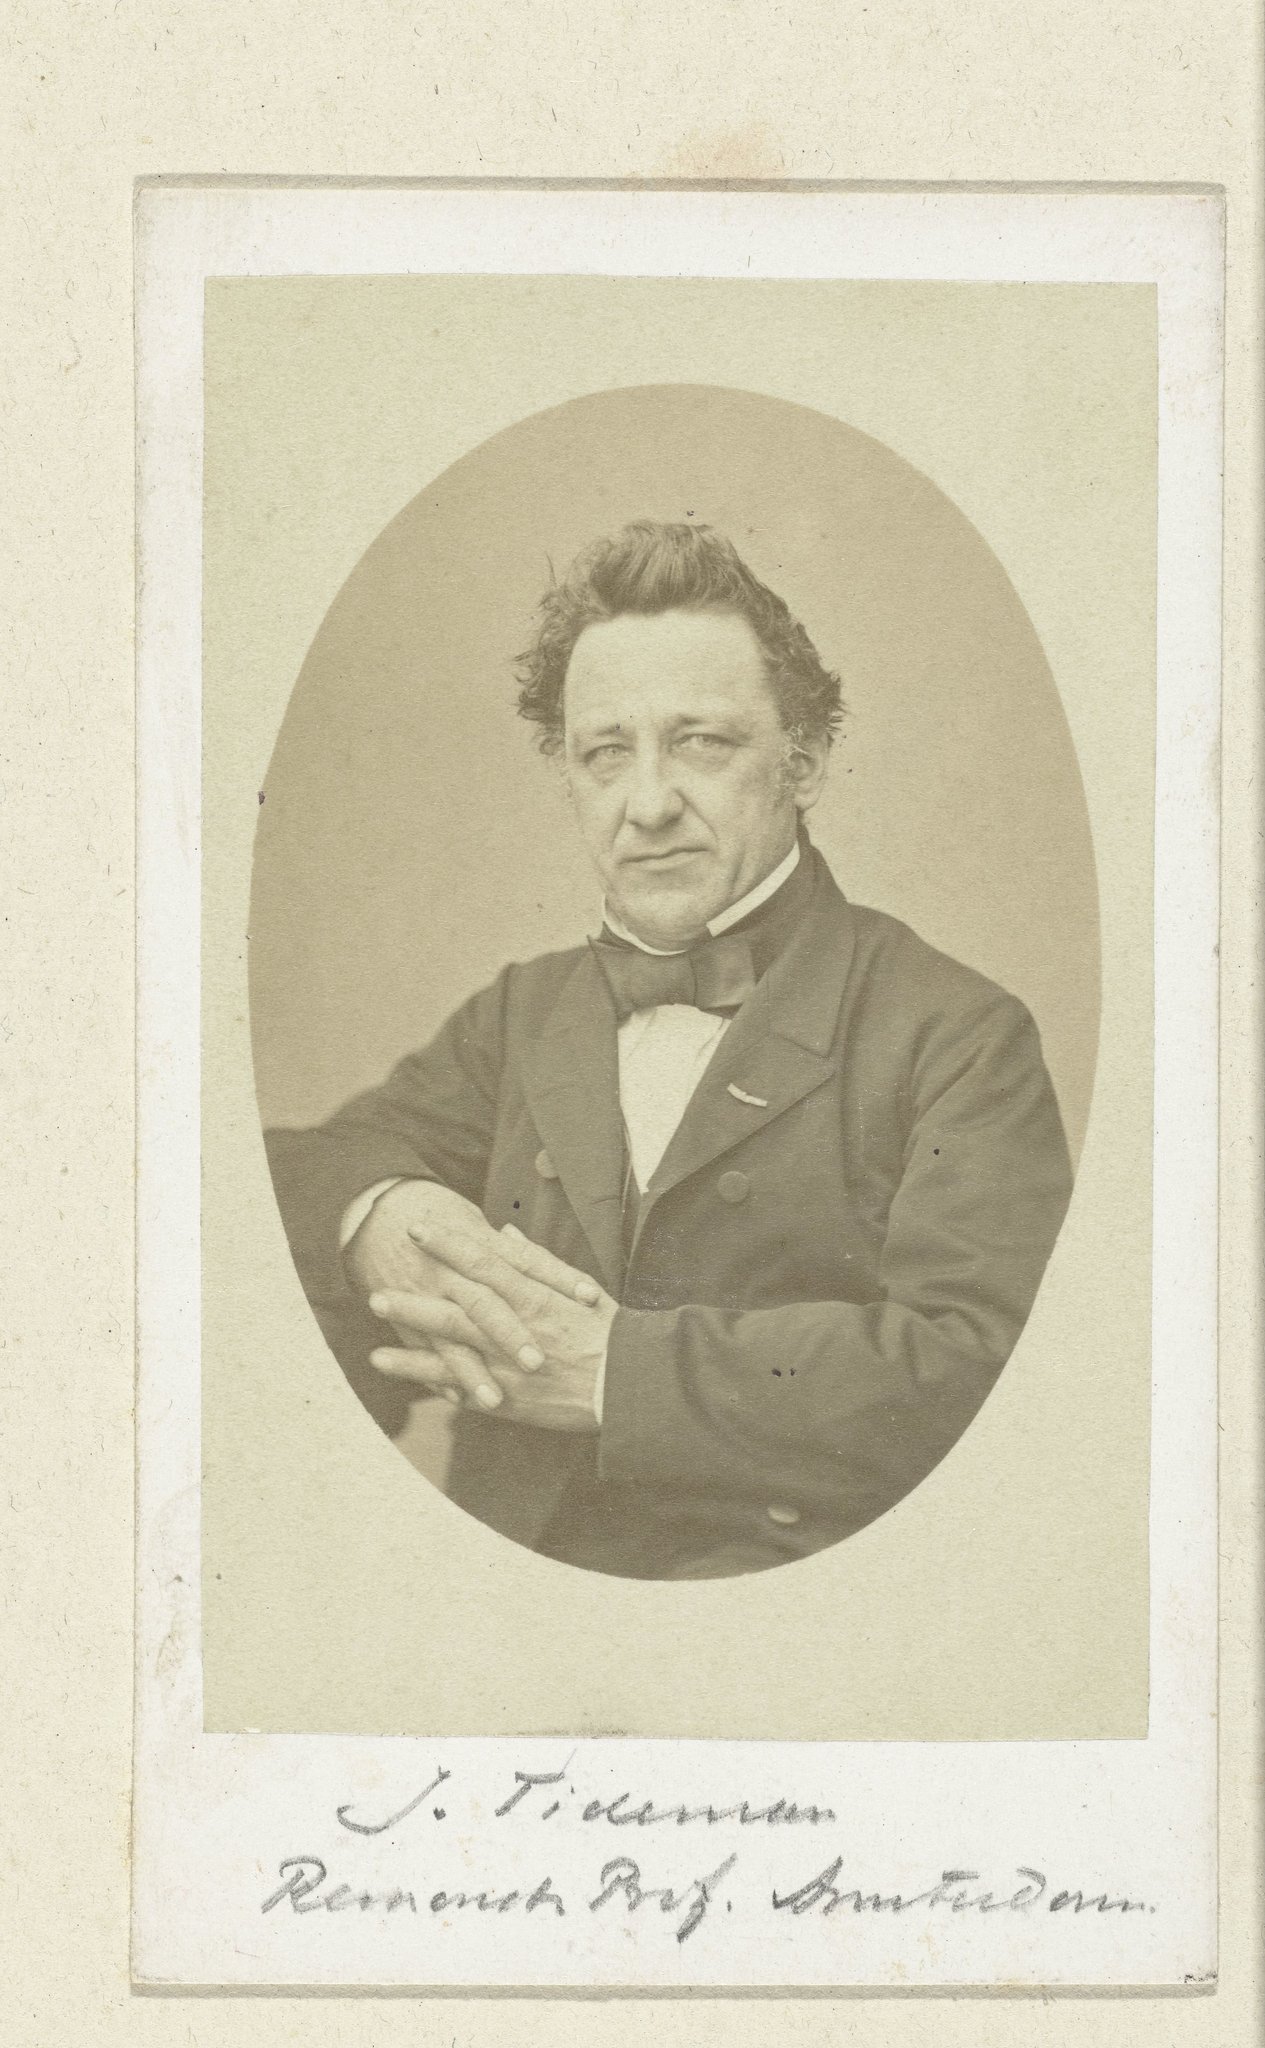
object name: carte de visite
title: J Tideman Remonstr. prof Amsterdam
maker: Anonymous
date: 1860-1887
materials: paper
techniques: albumen print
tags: historical persons (portraits and scenes from the life)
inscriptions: name: ‘J Tideman Remonstr. prof Amsterdam’